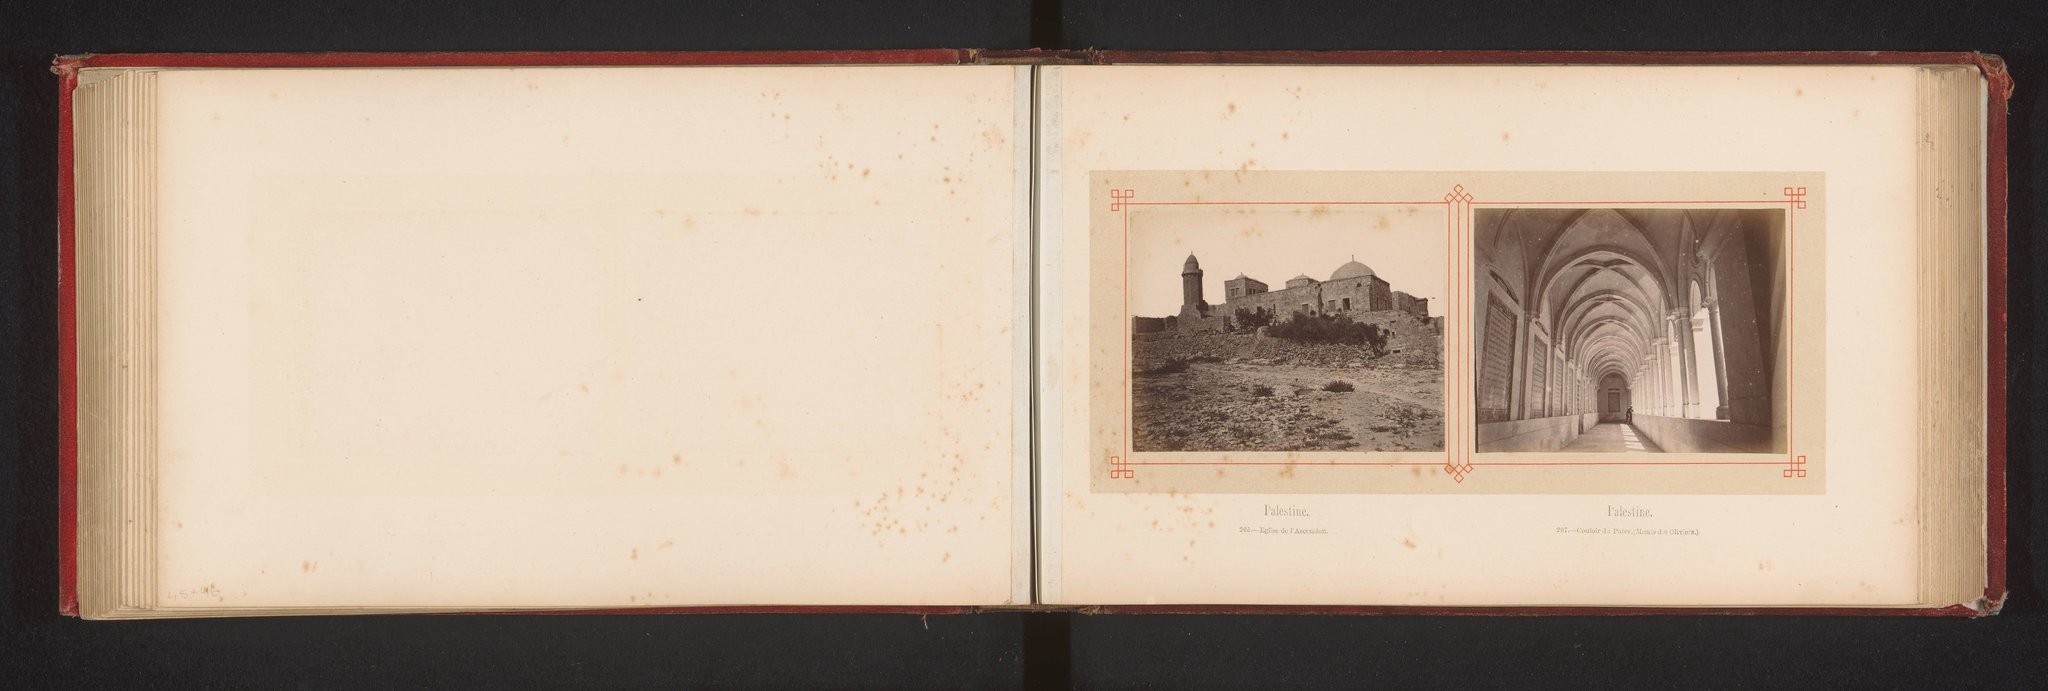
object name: photograph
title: Palestine - 203.- Église de ascension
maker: félix bonfils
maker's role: fotograaf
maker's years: 1831-1885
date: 1873-1878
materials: photographic support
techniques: albumen print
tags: church (exterior) - qq - small church, chapel